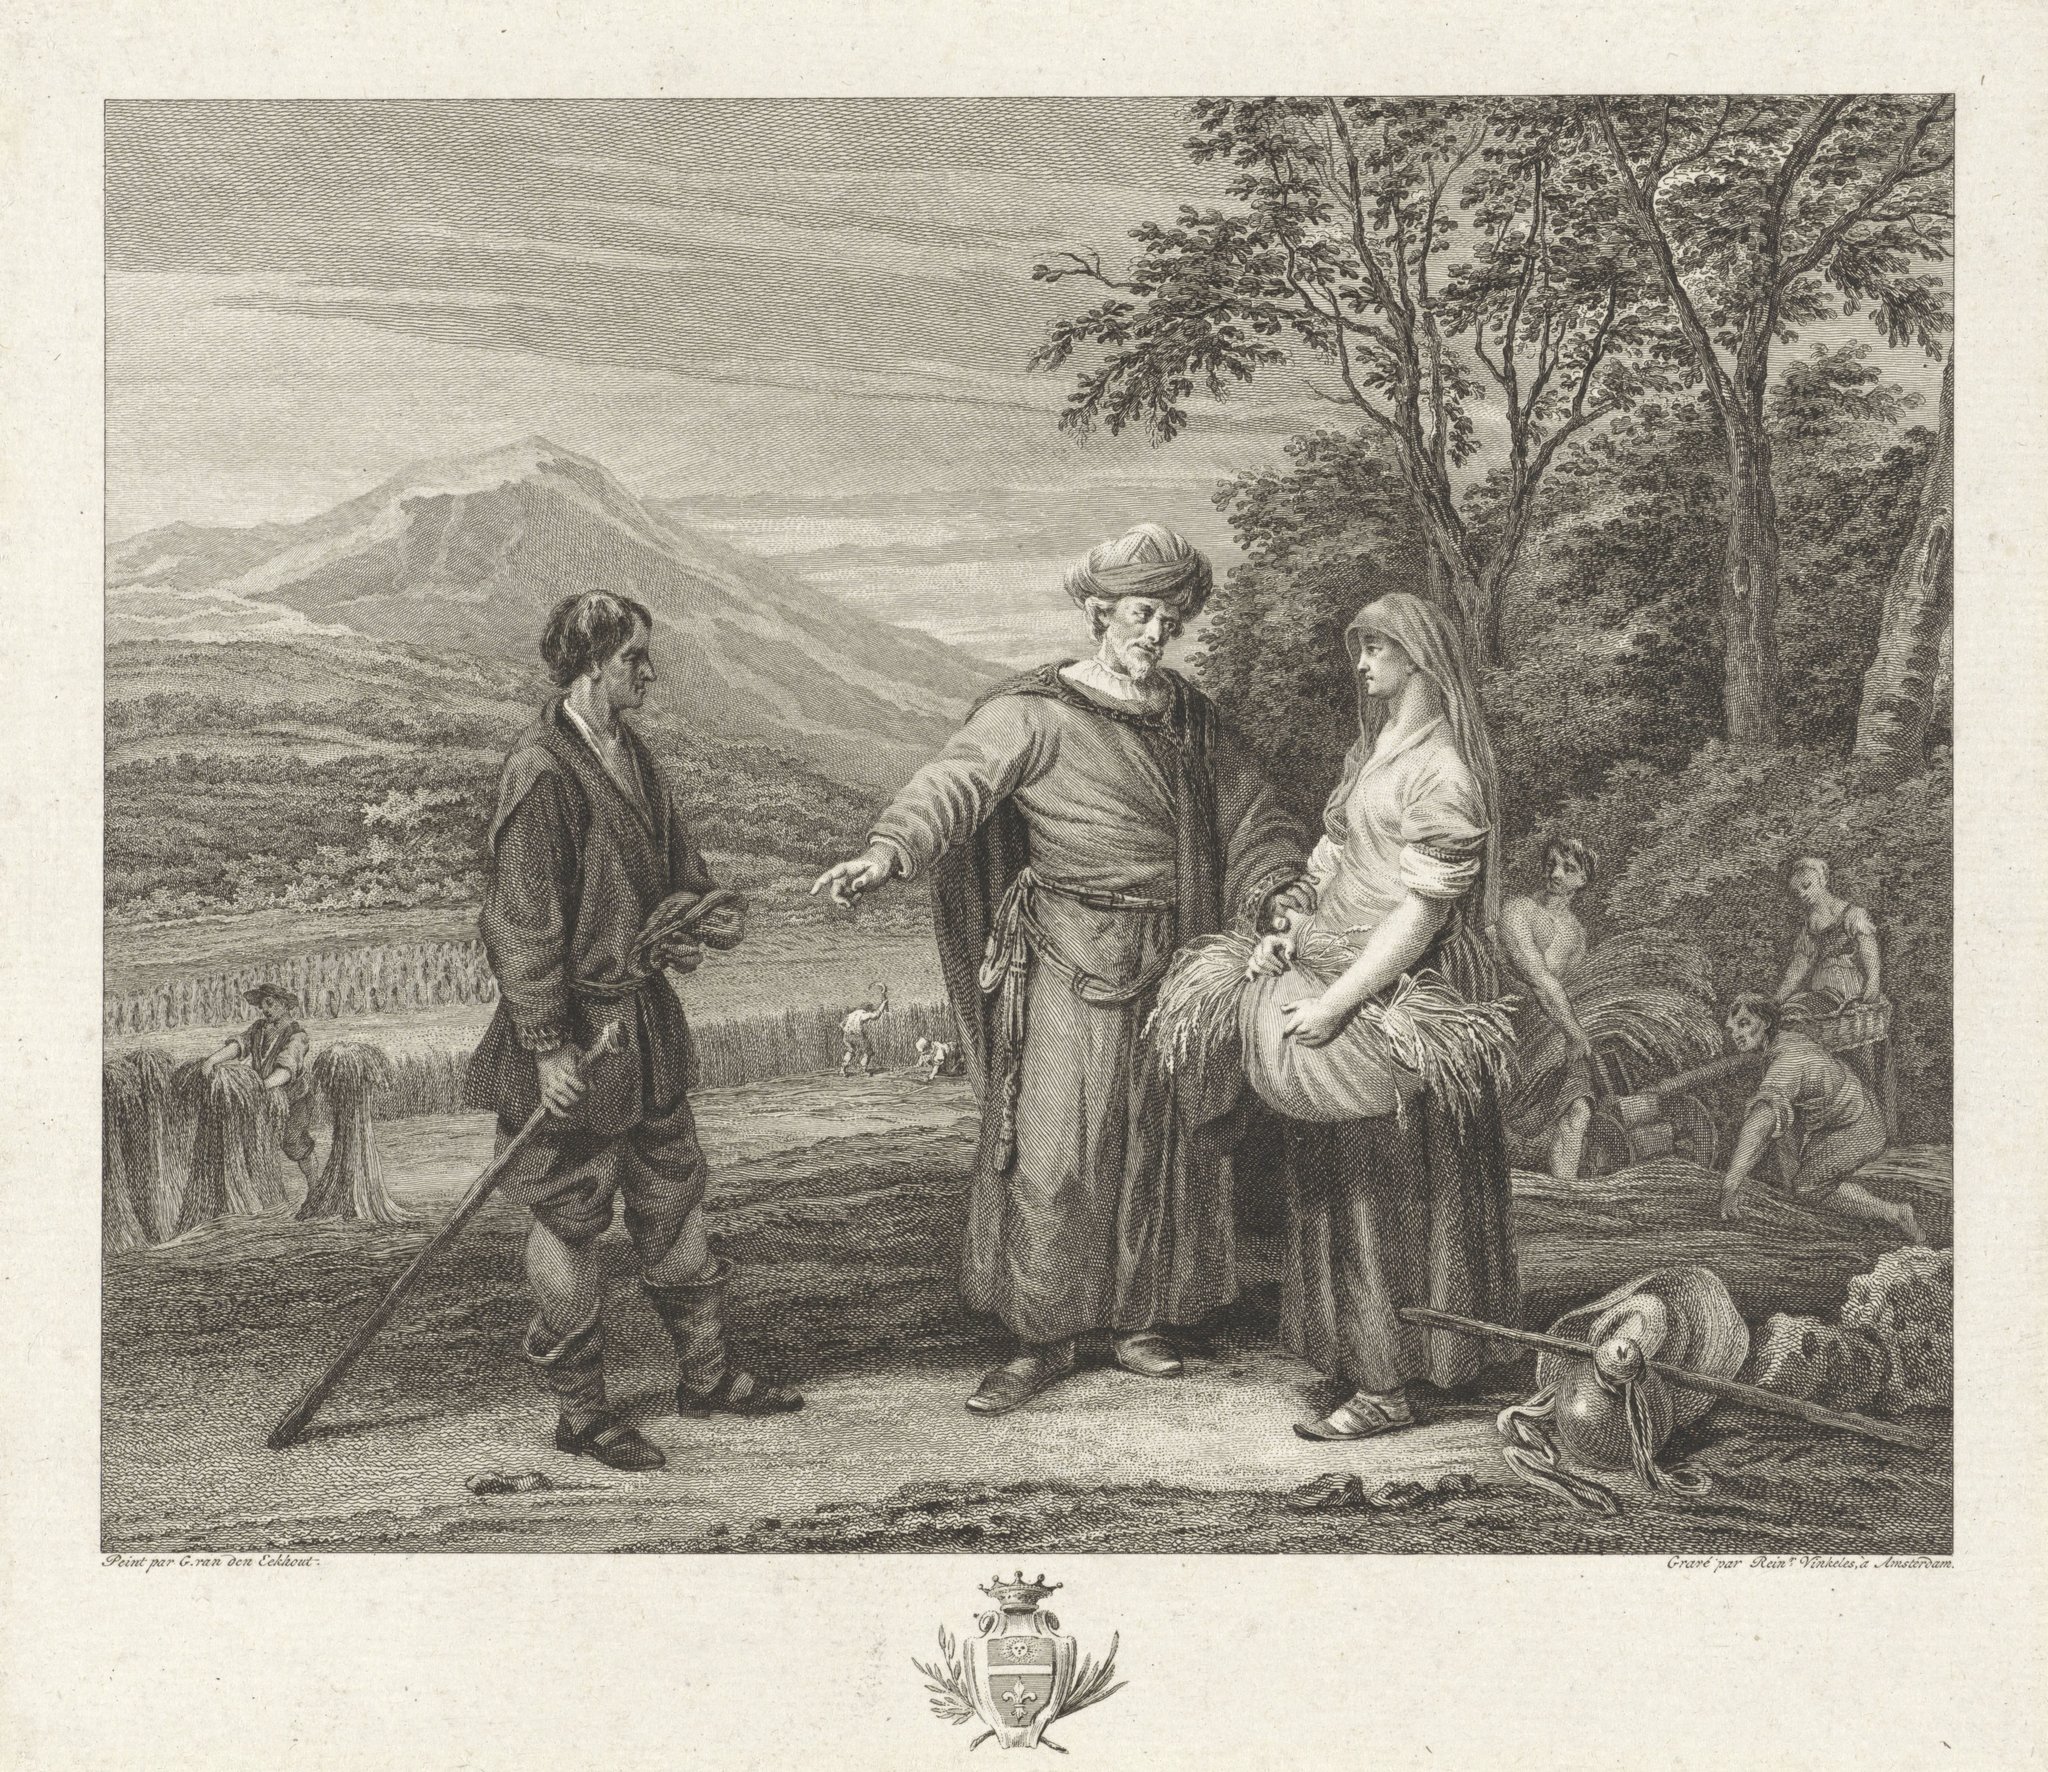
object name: print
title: Boaz en Ruth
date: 1751-1816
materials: paper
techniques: engraving, etching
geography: amsterdam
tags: ruth in the field of boaz (ruth 2:3-17)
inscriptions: collector's mark: Lugt 2228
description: Boaz, met baard en tulband, instrueert zijn maaiers om Ruth, met in haar handen een bundel korenaren, goed te behandelen. Scène uit het bijbelverhaal Ruth: 2.